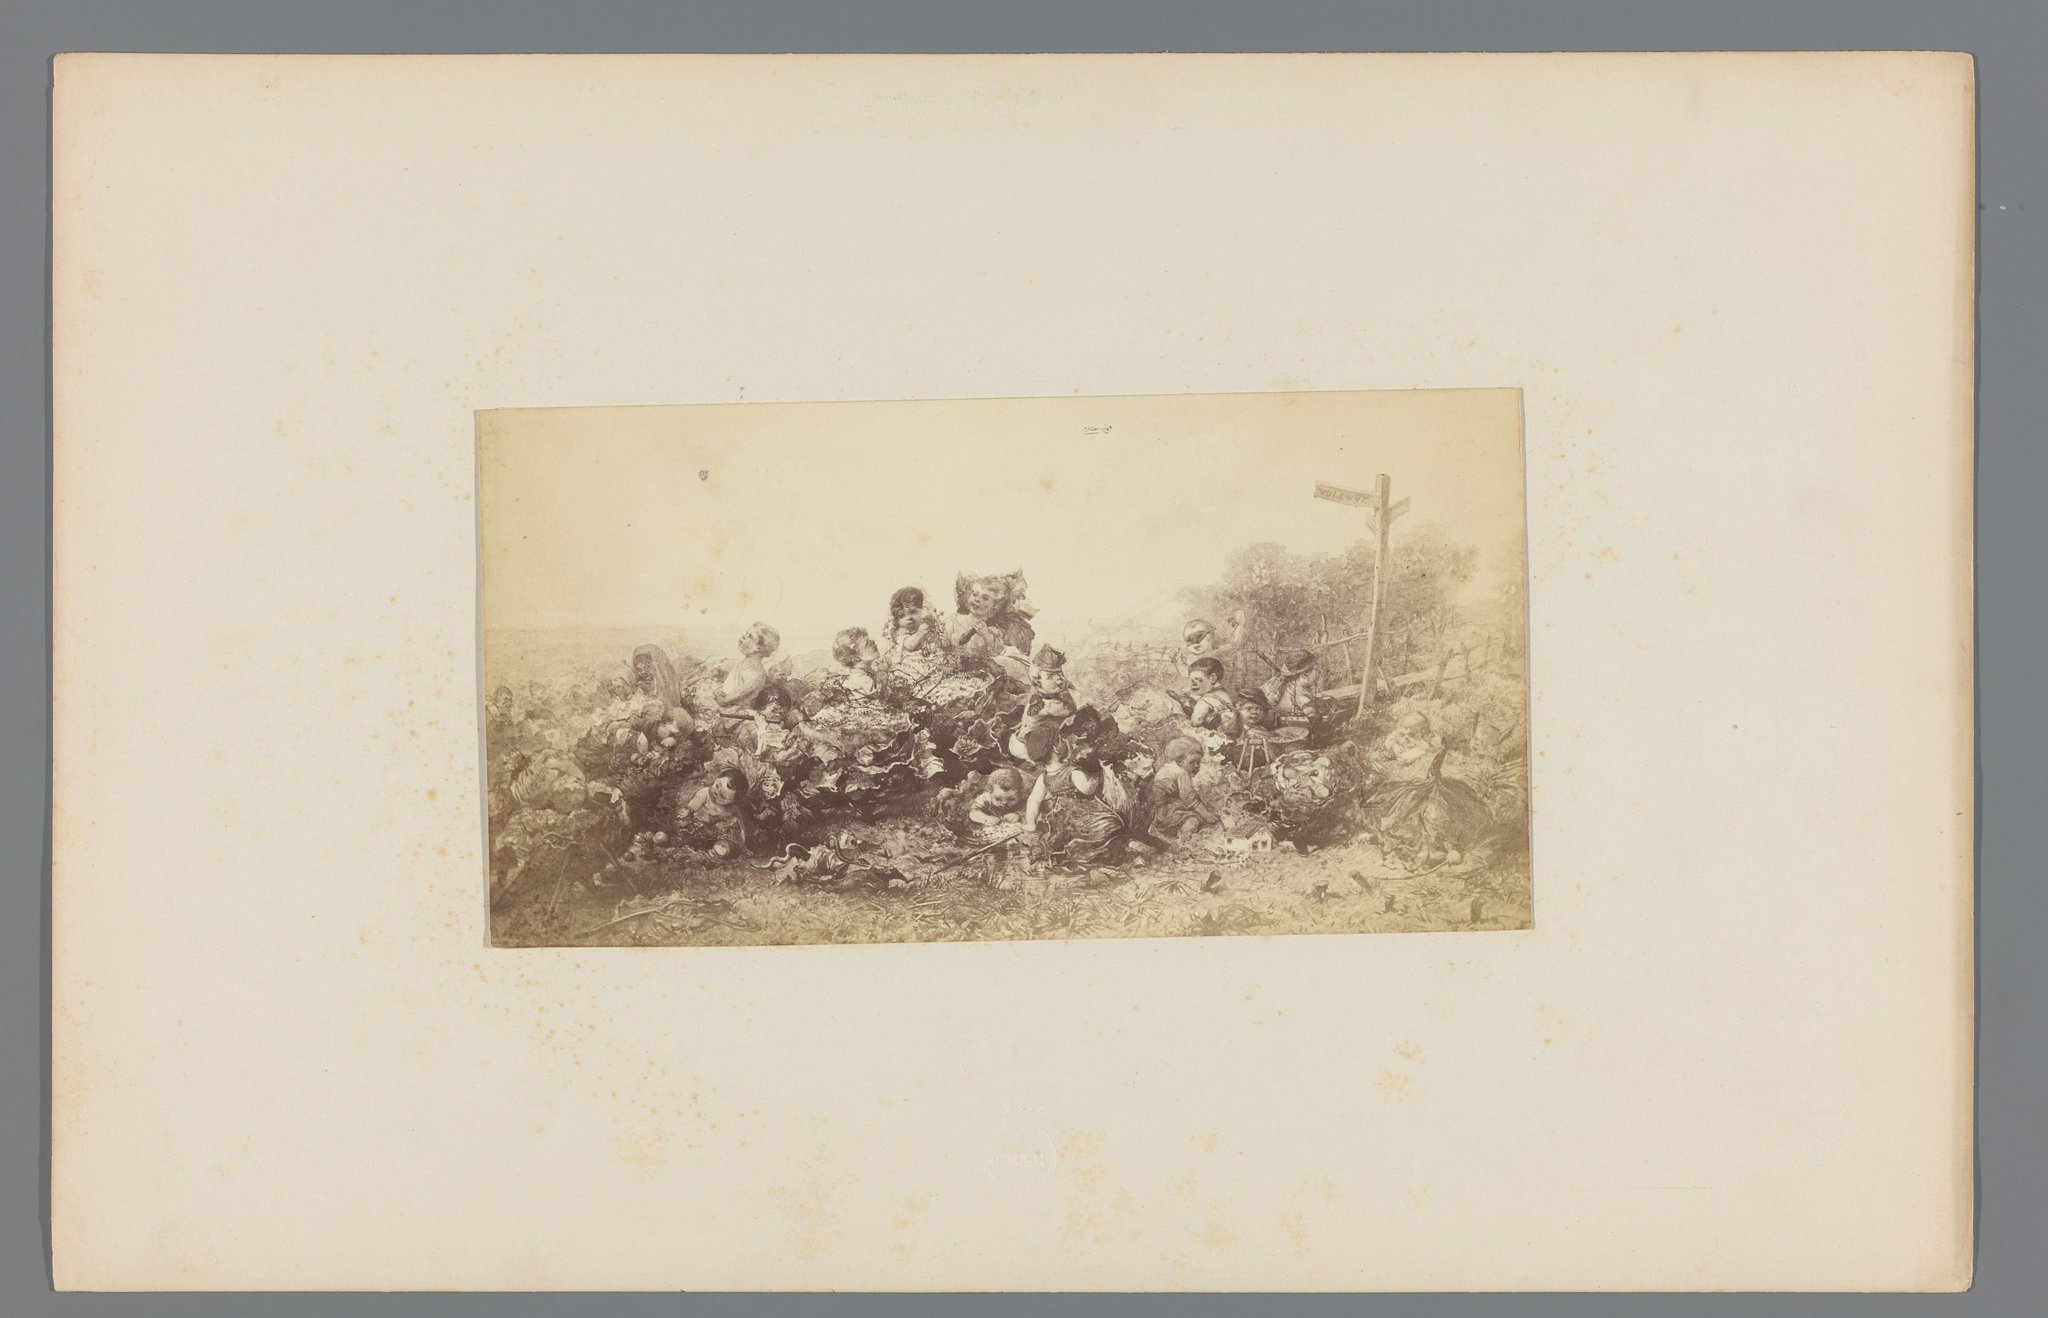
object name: page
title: Fotoreproductie van het schilderij 'Volewijk' door Mari ten Kate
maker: mari ten kate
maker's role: draughtsman, painter, print maker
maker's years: 1831-1910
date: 1866-1871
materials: paper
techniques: albumen print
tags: children's games and plays